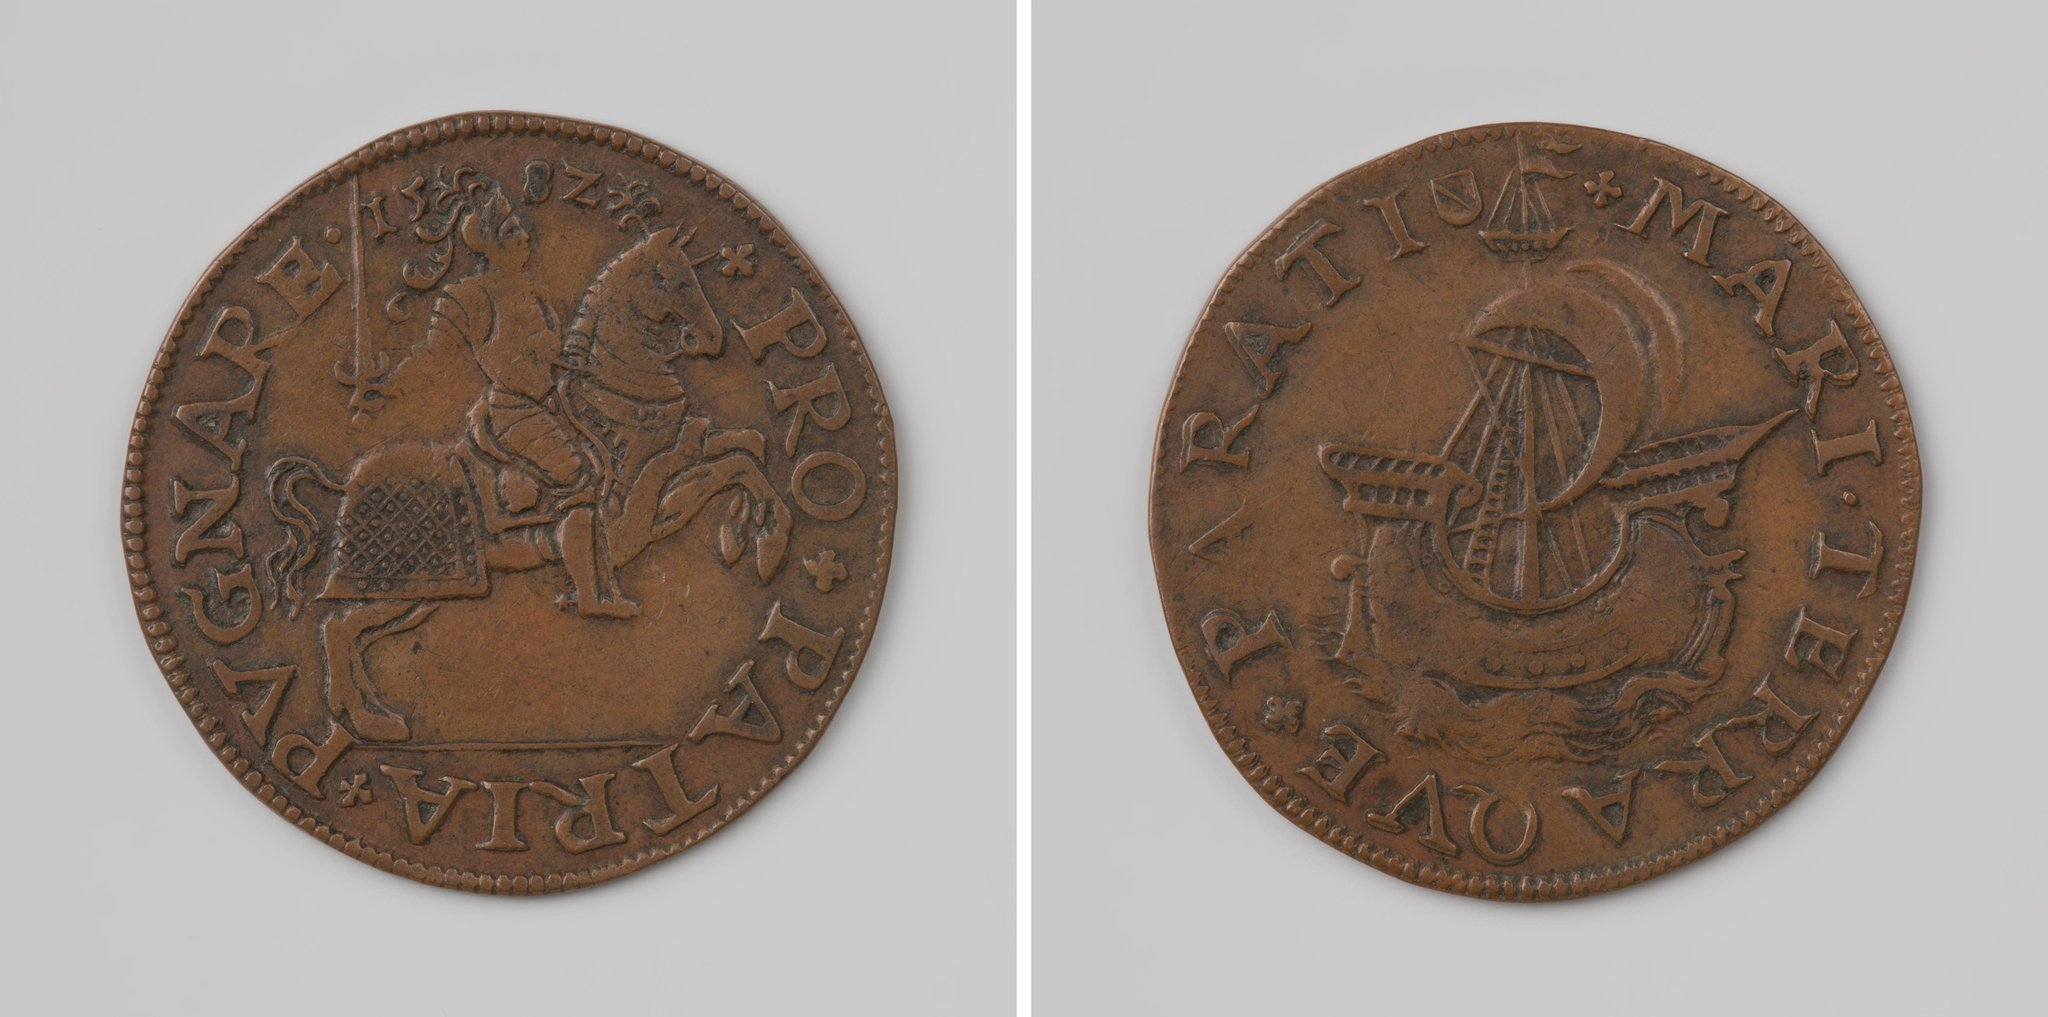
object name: jeton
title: Bereidheid van de Staten van Utrecht om de strijd tegen de Spanjaarden voort te zetten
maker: Anonymous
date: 1582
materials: copper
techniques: striking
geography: utrecht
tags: utrecht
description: Koperen penning. Voorzijde: geharnaste ruiter met getrokken zwaard in hand binnen omschrift. Keerzijde: schip op zee binnen omschrift